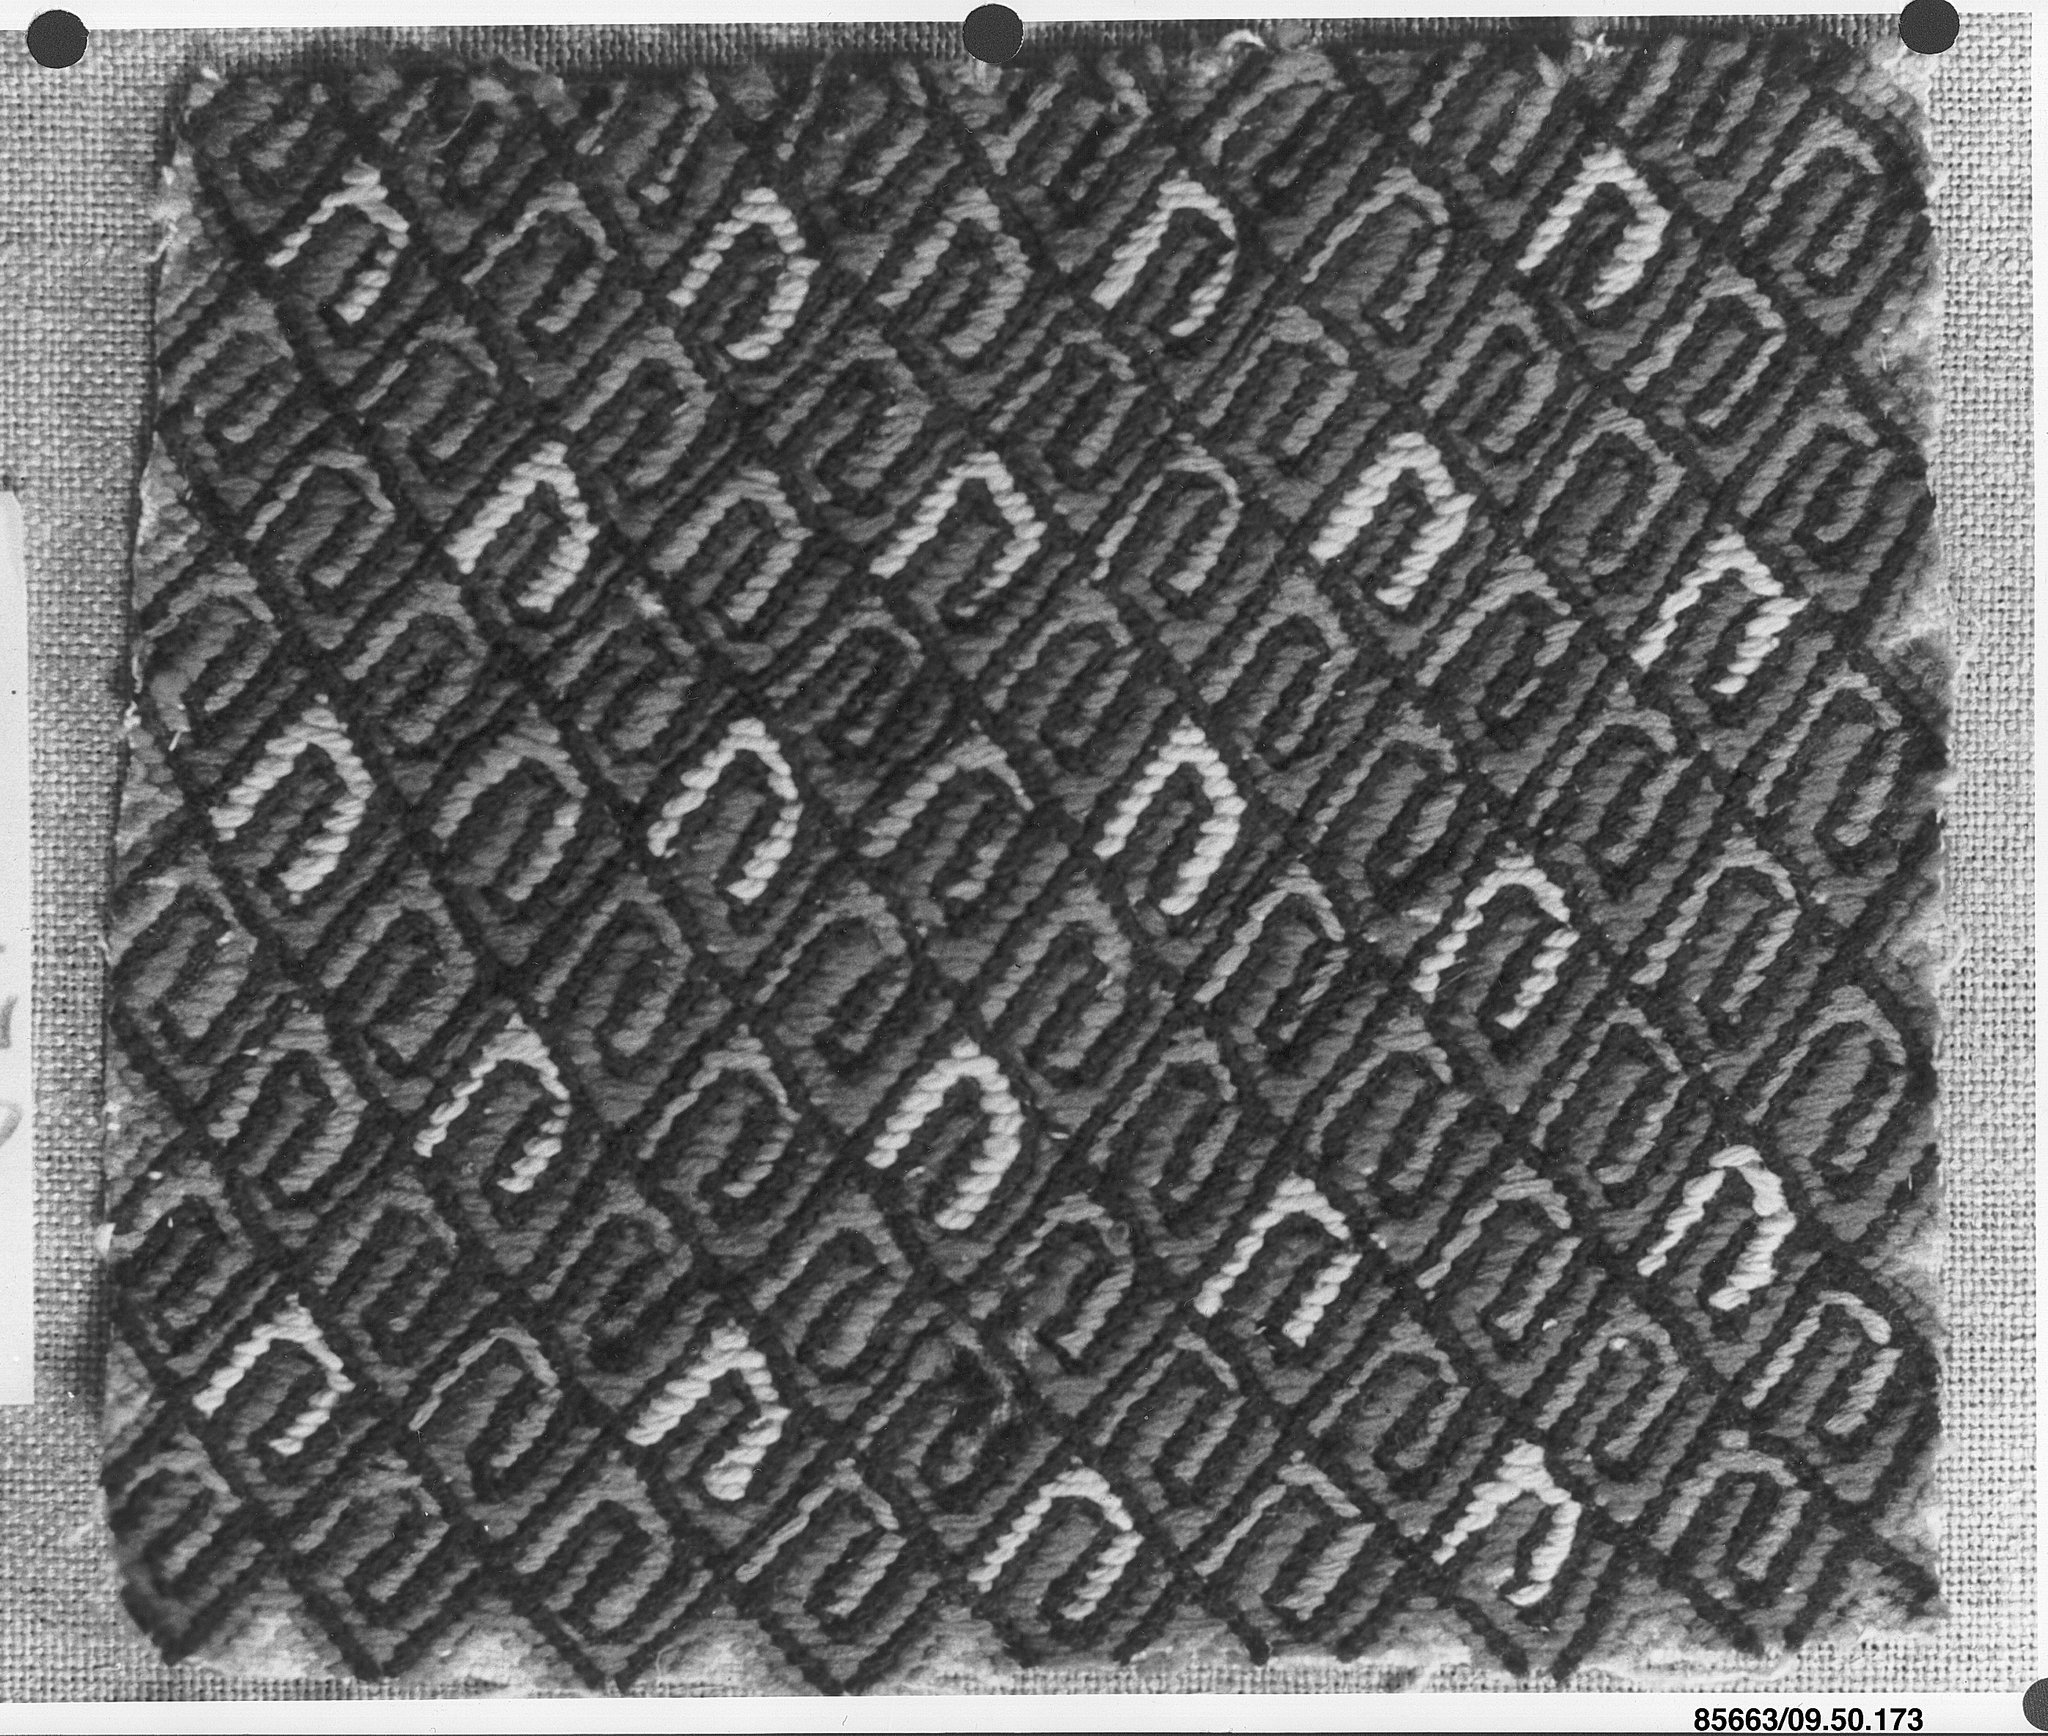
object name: costume fragment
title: Peasant costume fragment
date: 1701-1900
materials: canvas, wool